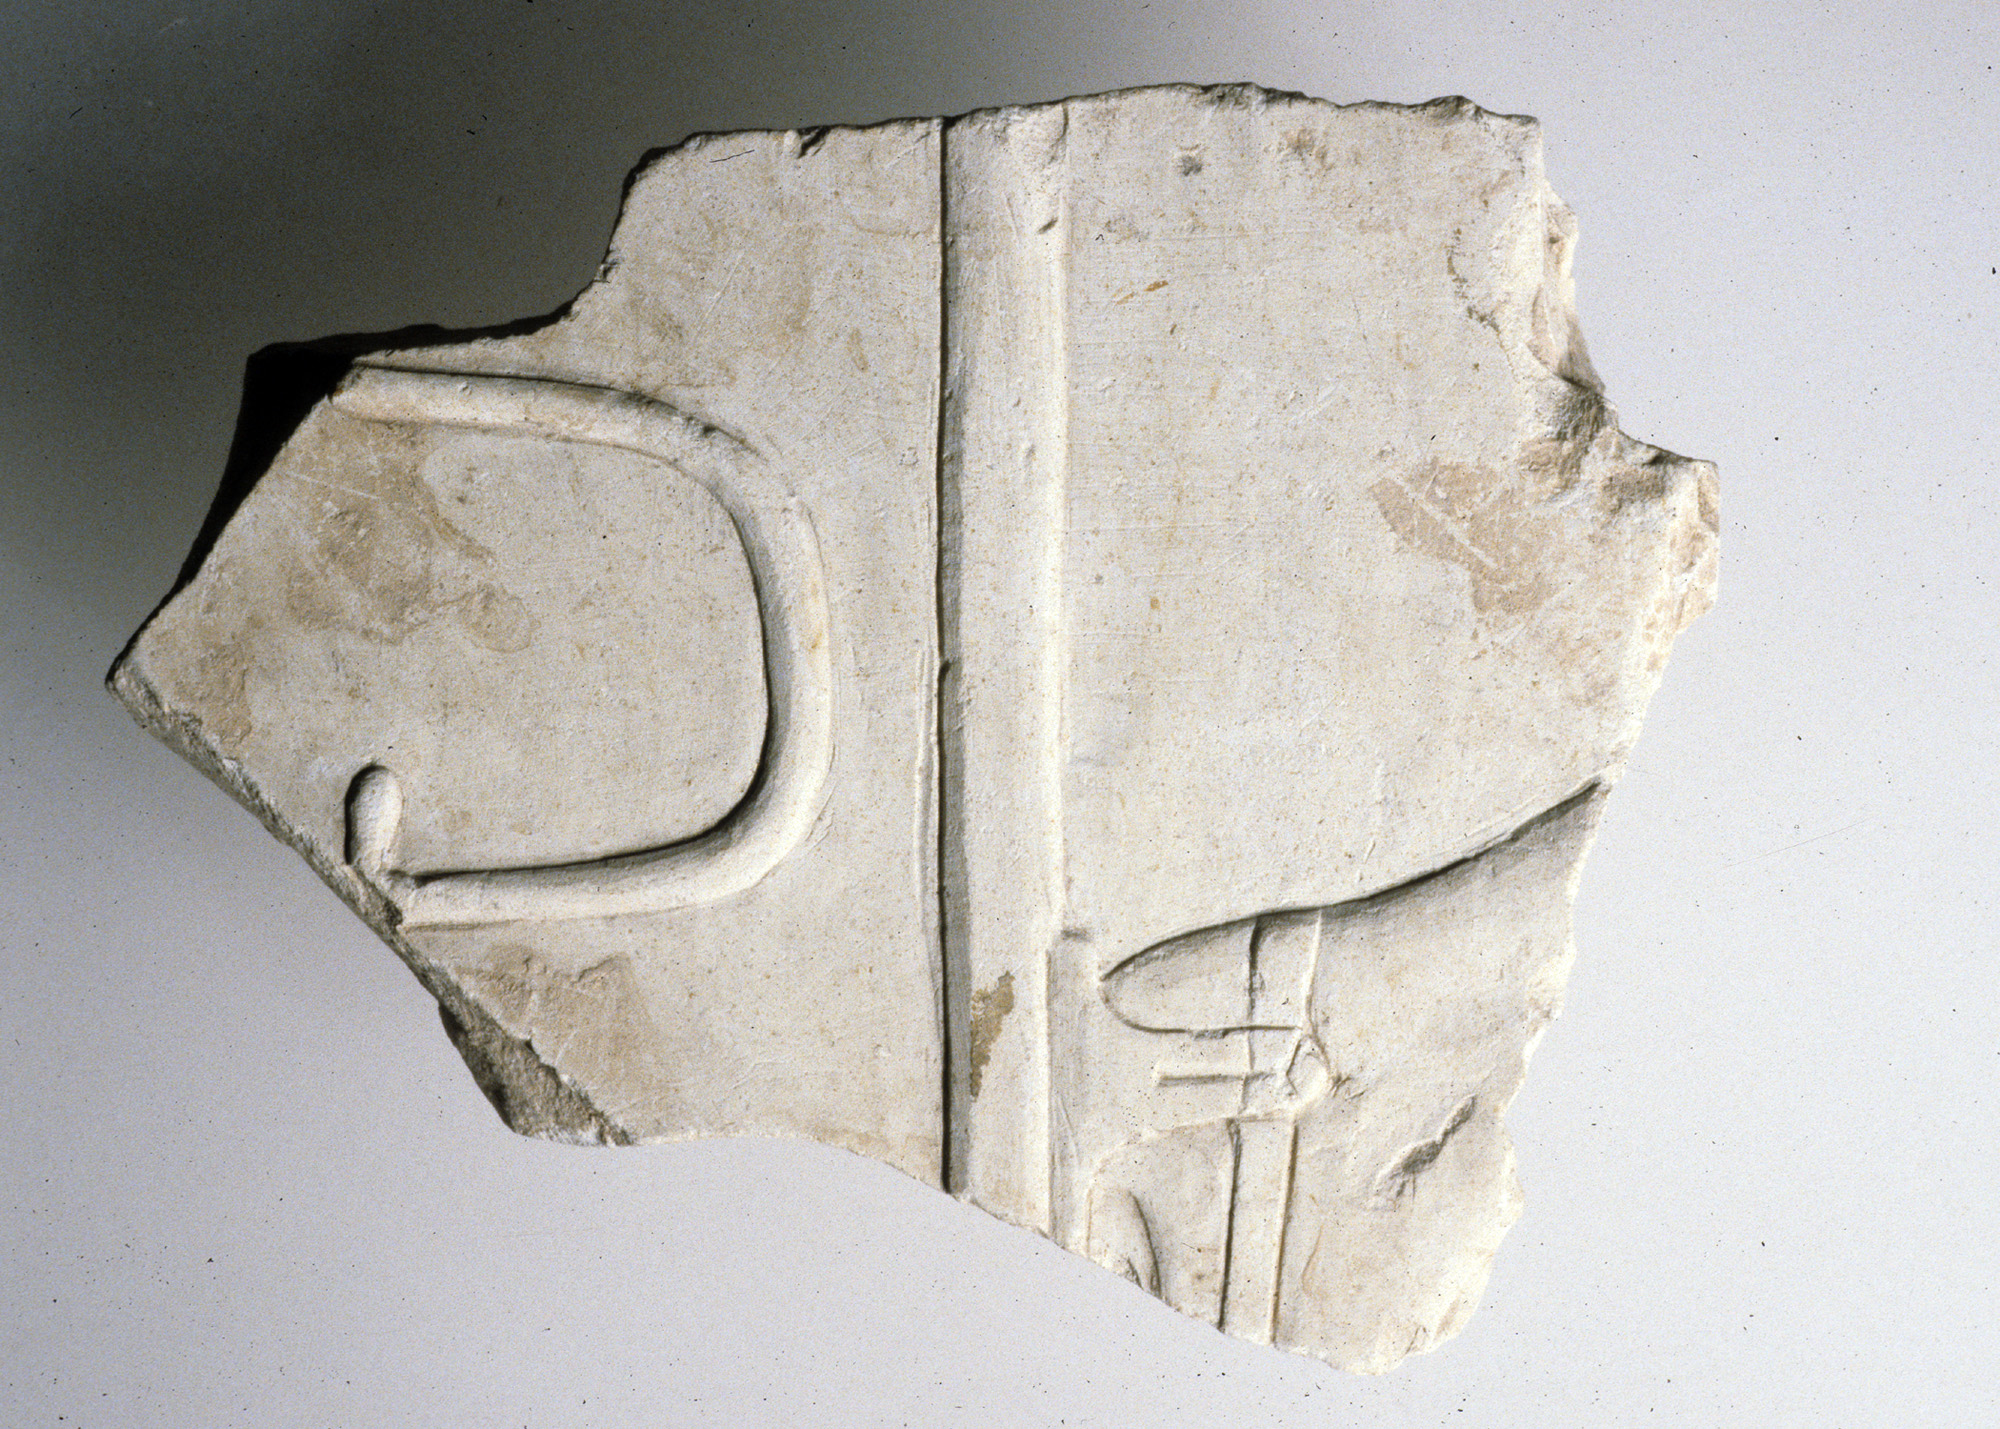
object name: relief fragment, tomb of meketre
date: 1981-1975 BCE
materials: limestone, paint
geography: egypt